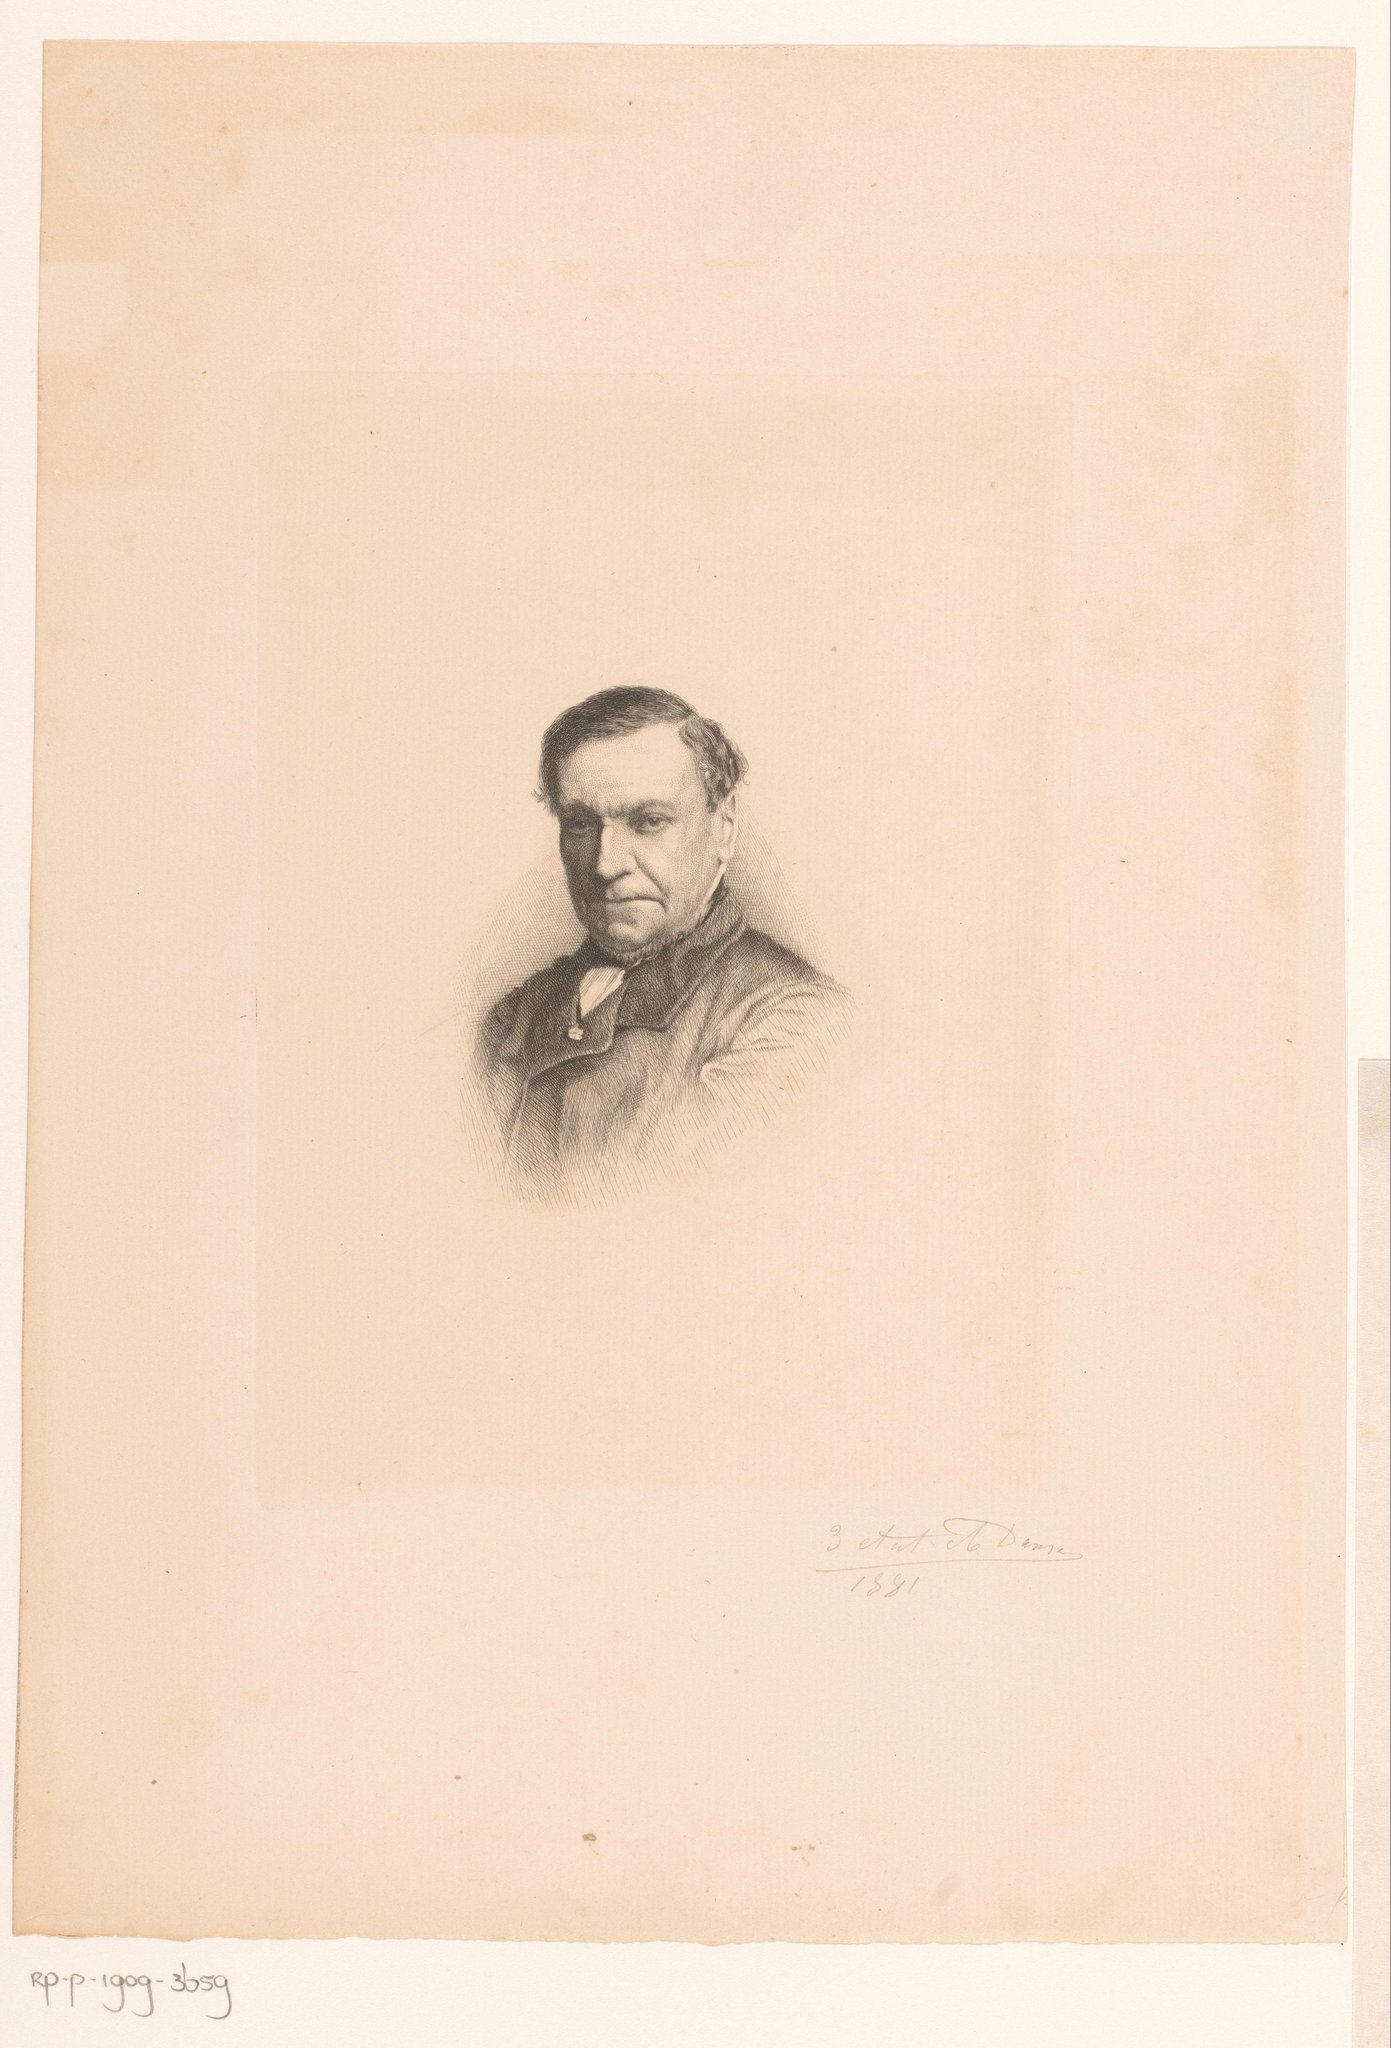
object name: print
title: Portret van Eugène Verboeckhoven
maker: auguste danse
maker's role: print maker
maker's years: 1829-1929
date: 1881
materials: paper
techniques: etching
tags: painter, draughtsman, printer, eugène verboeckhoven, historical person (...) - historical person (...) portrayed alone, portrait, self-portrait of painter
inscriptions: collector's mark: Lugt 2228, annotation: ‘3 etat’